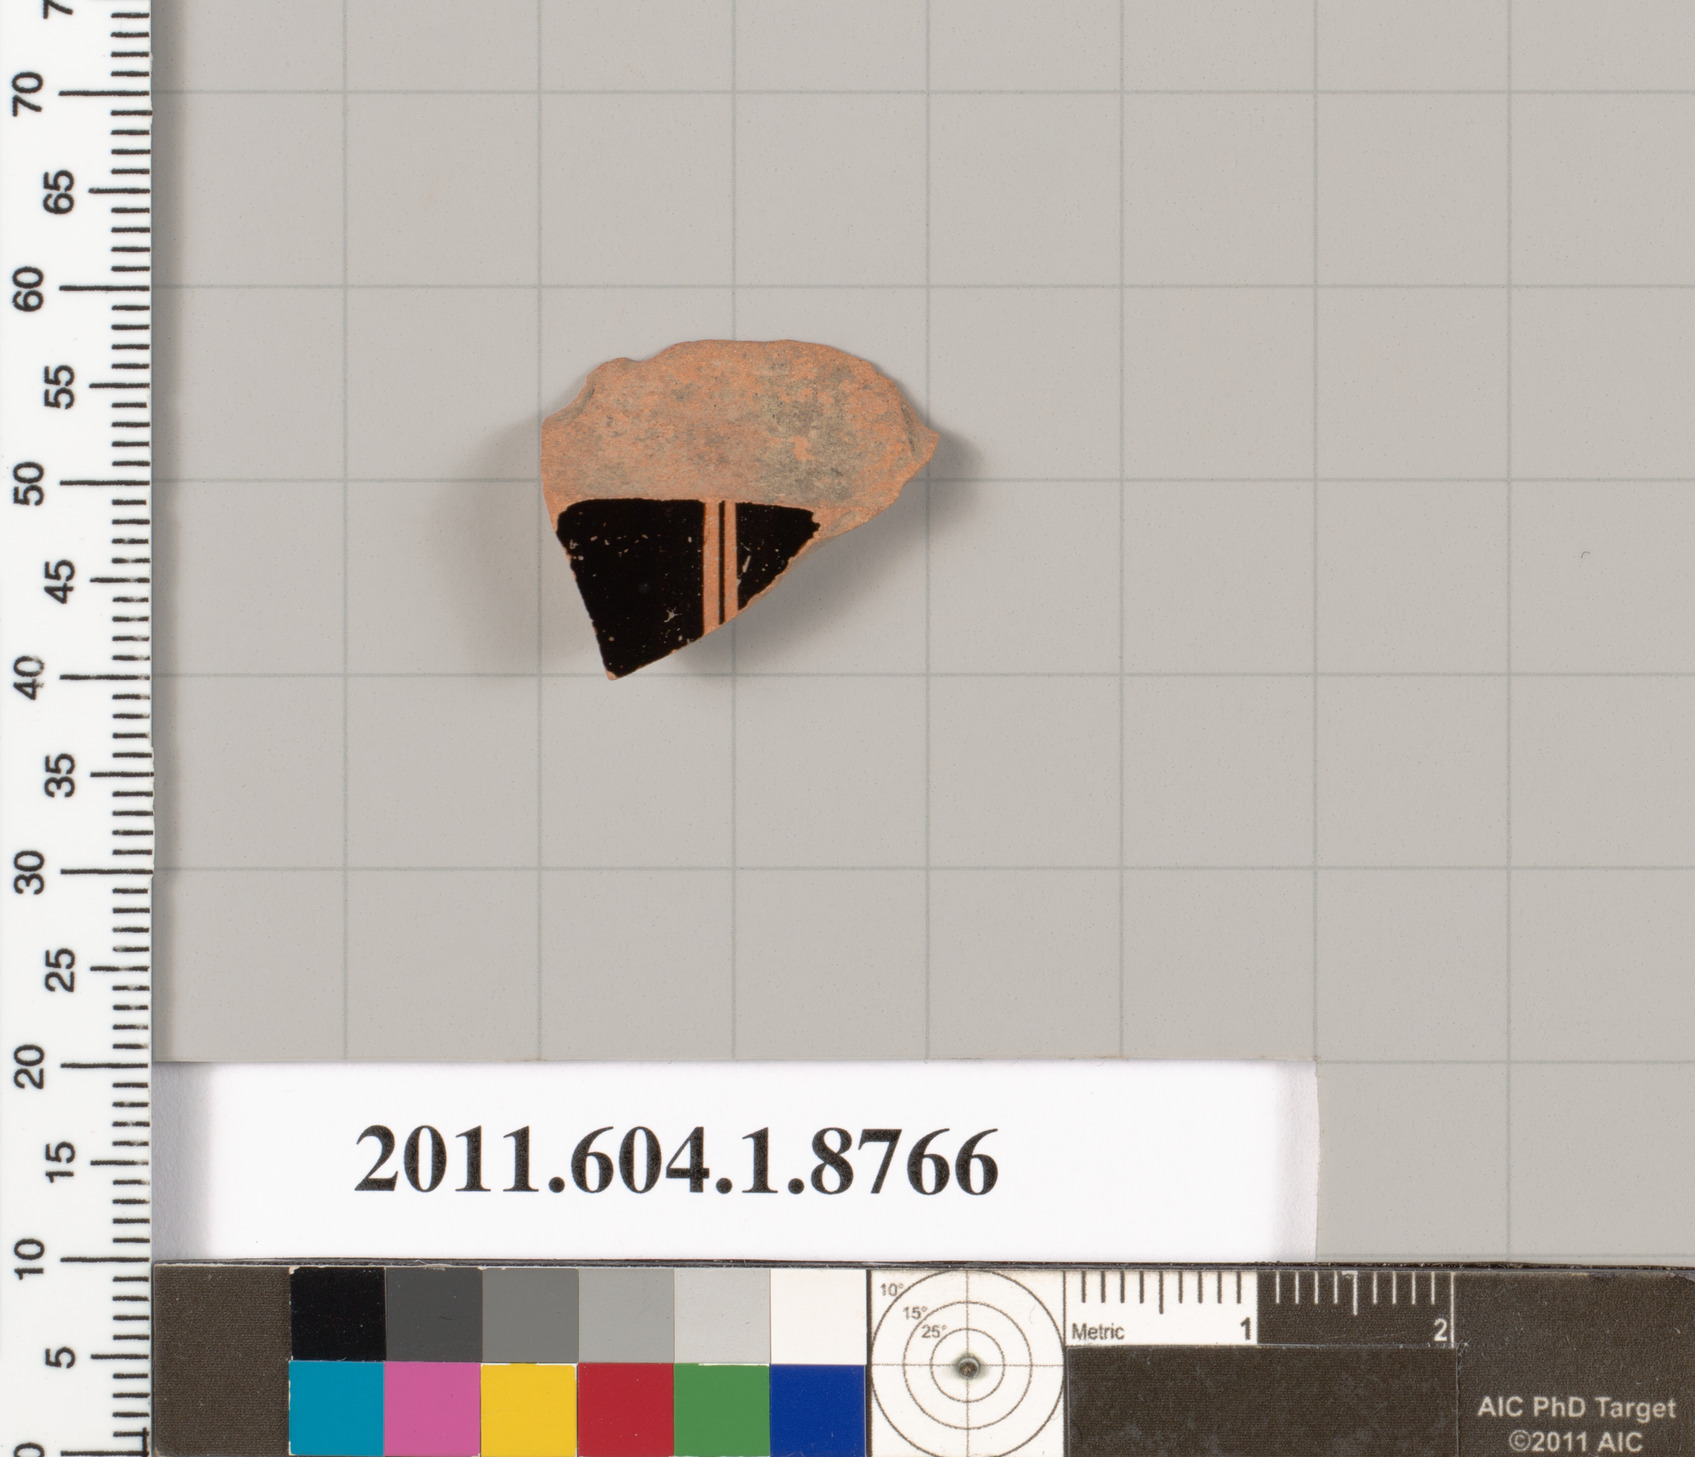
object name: kylix fragment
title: Terracotta fragment of a kylix (drinking cup)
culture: greek, attic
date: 490-480 BCE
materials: terracotta